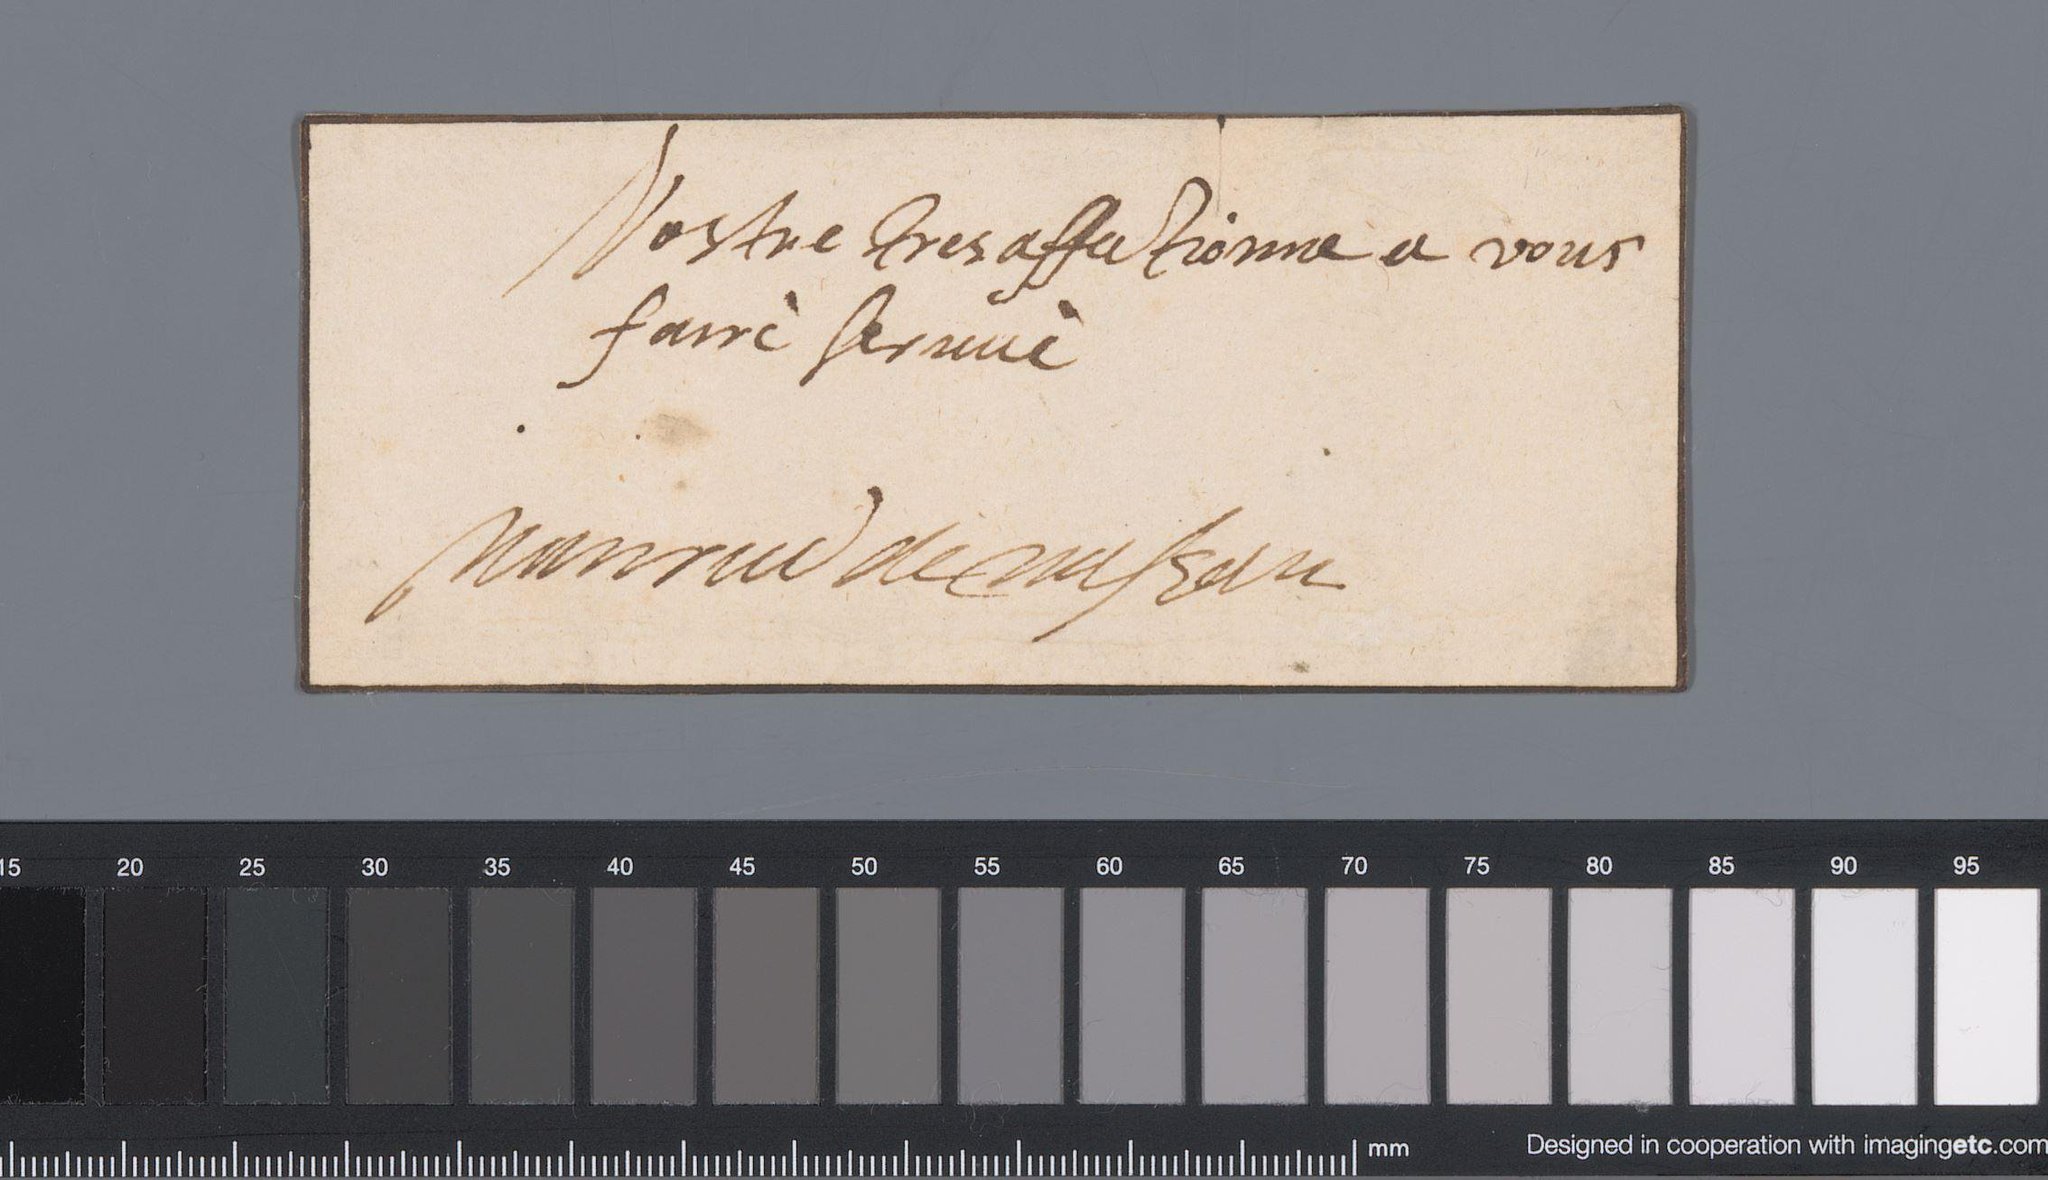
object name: document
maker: maurice (prince of orange)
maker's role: legeraanvoerder, stadhouder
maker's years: 1567-1625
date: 1575-1625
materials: ink, paper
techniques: writing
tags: the hague, maurice (prince of orange)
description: Handtekening in bruine inkt (van prins Maurits van Oranje), op uitgeknipt blaadje papier. Gesigneerd: Maurice de Nassau. Opschrift: 'Vostre tres affectionne et vous farre .....'.